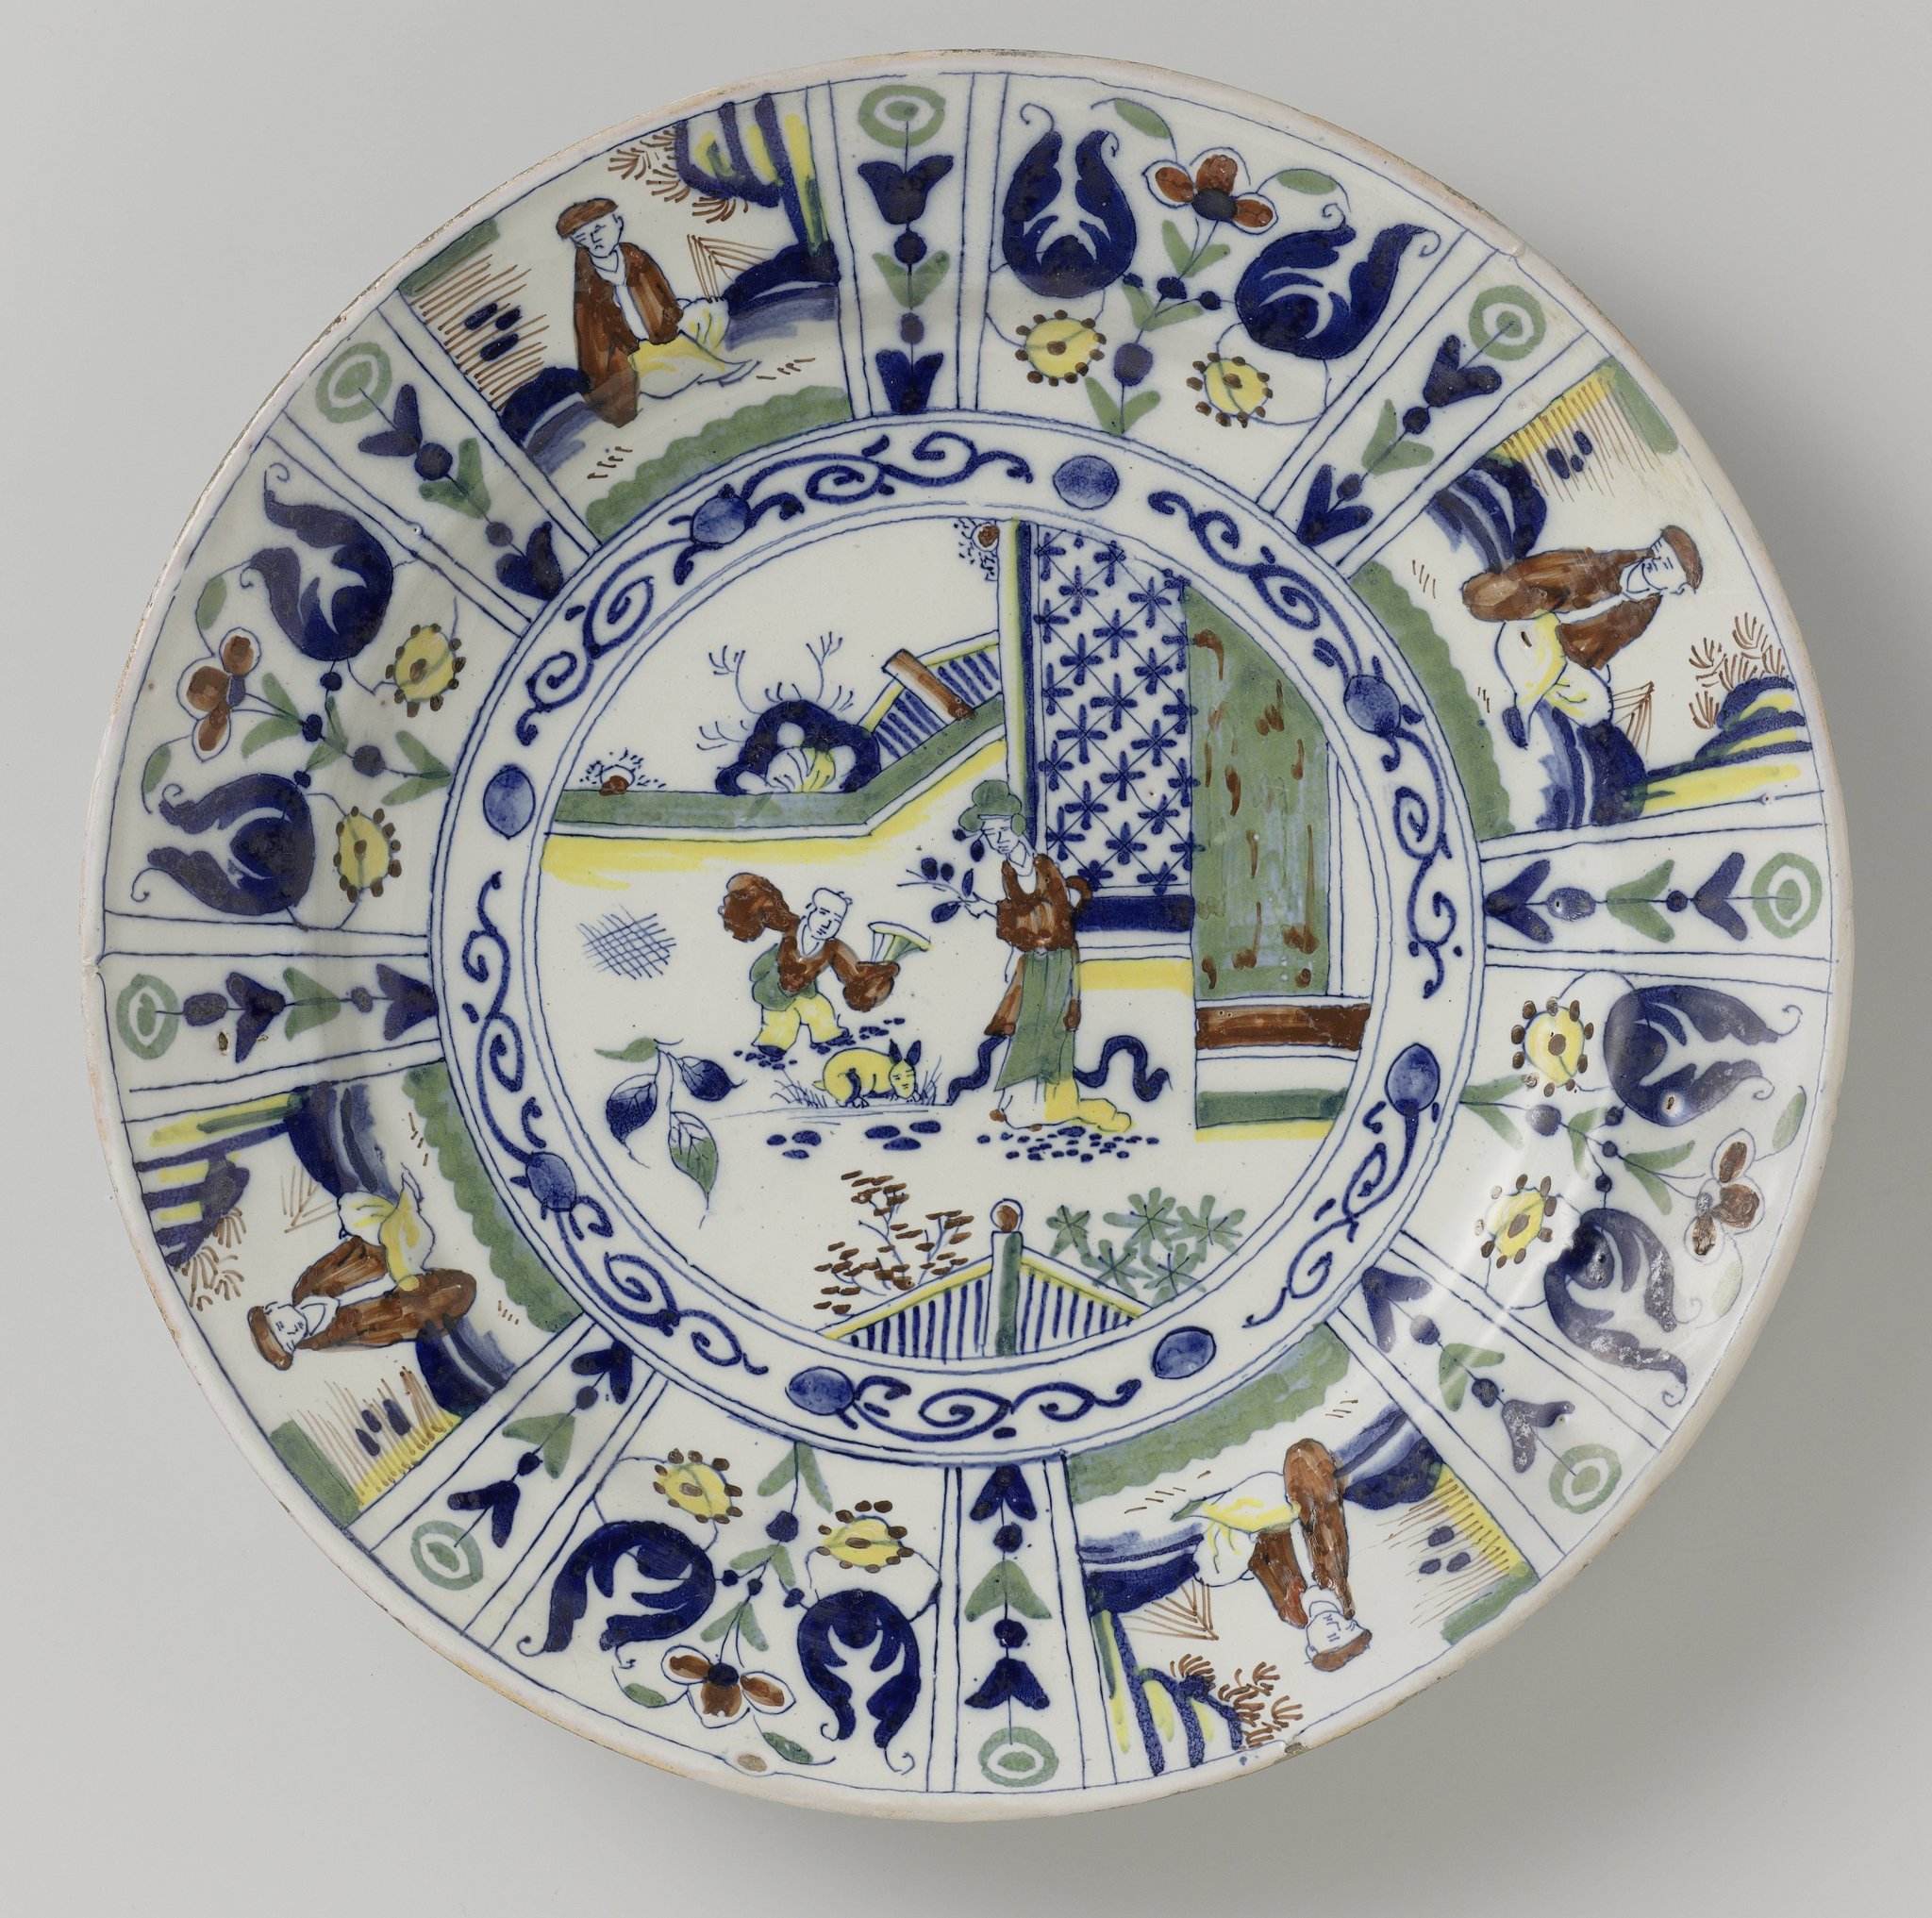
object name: platter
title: Schotel met Chinezen in tuin.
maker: Anonymous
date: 1780-1830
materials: earthenware, glaze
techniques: painted, polychromy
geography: delft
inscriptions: collector's mark: ‘koninklijk oudheidkundig genootschap no. 2’, mark: ‘3’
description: Ronde schotel van veelkleurig beschilderde faience, met op het plat een Chinese man en een vrouw in een tuin. De rand is verdeeld in acht brede vakken. In vier vakken is een zittende man afgebeeld, in de andere vier vakken bloemen. Tussen elk breed vak is een smal vak met een bloemmotief. De versieringen zijn in de kleuren blauw, groen, geel en bruin. Op de achterzijde staat het getal 3.